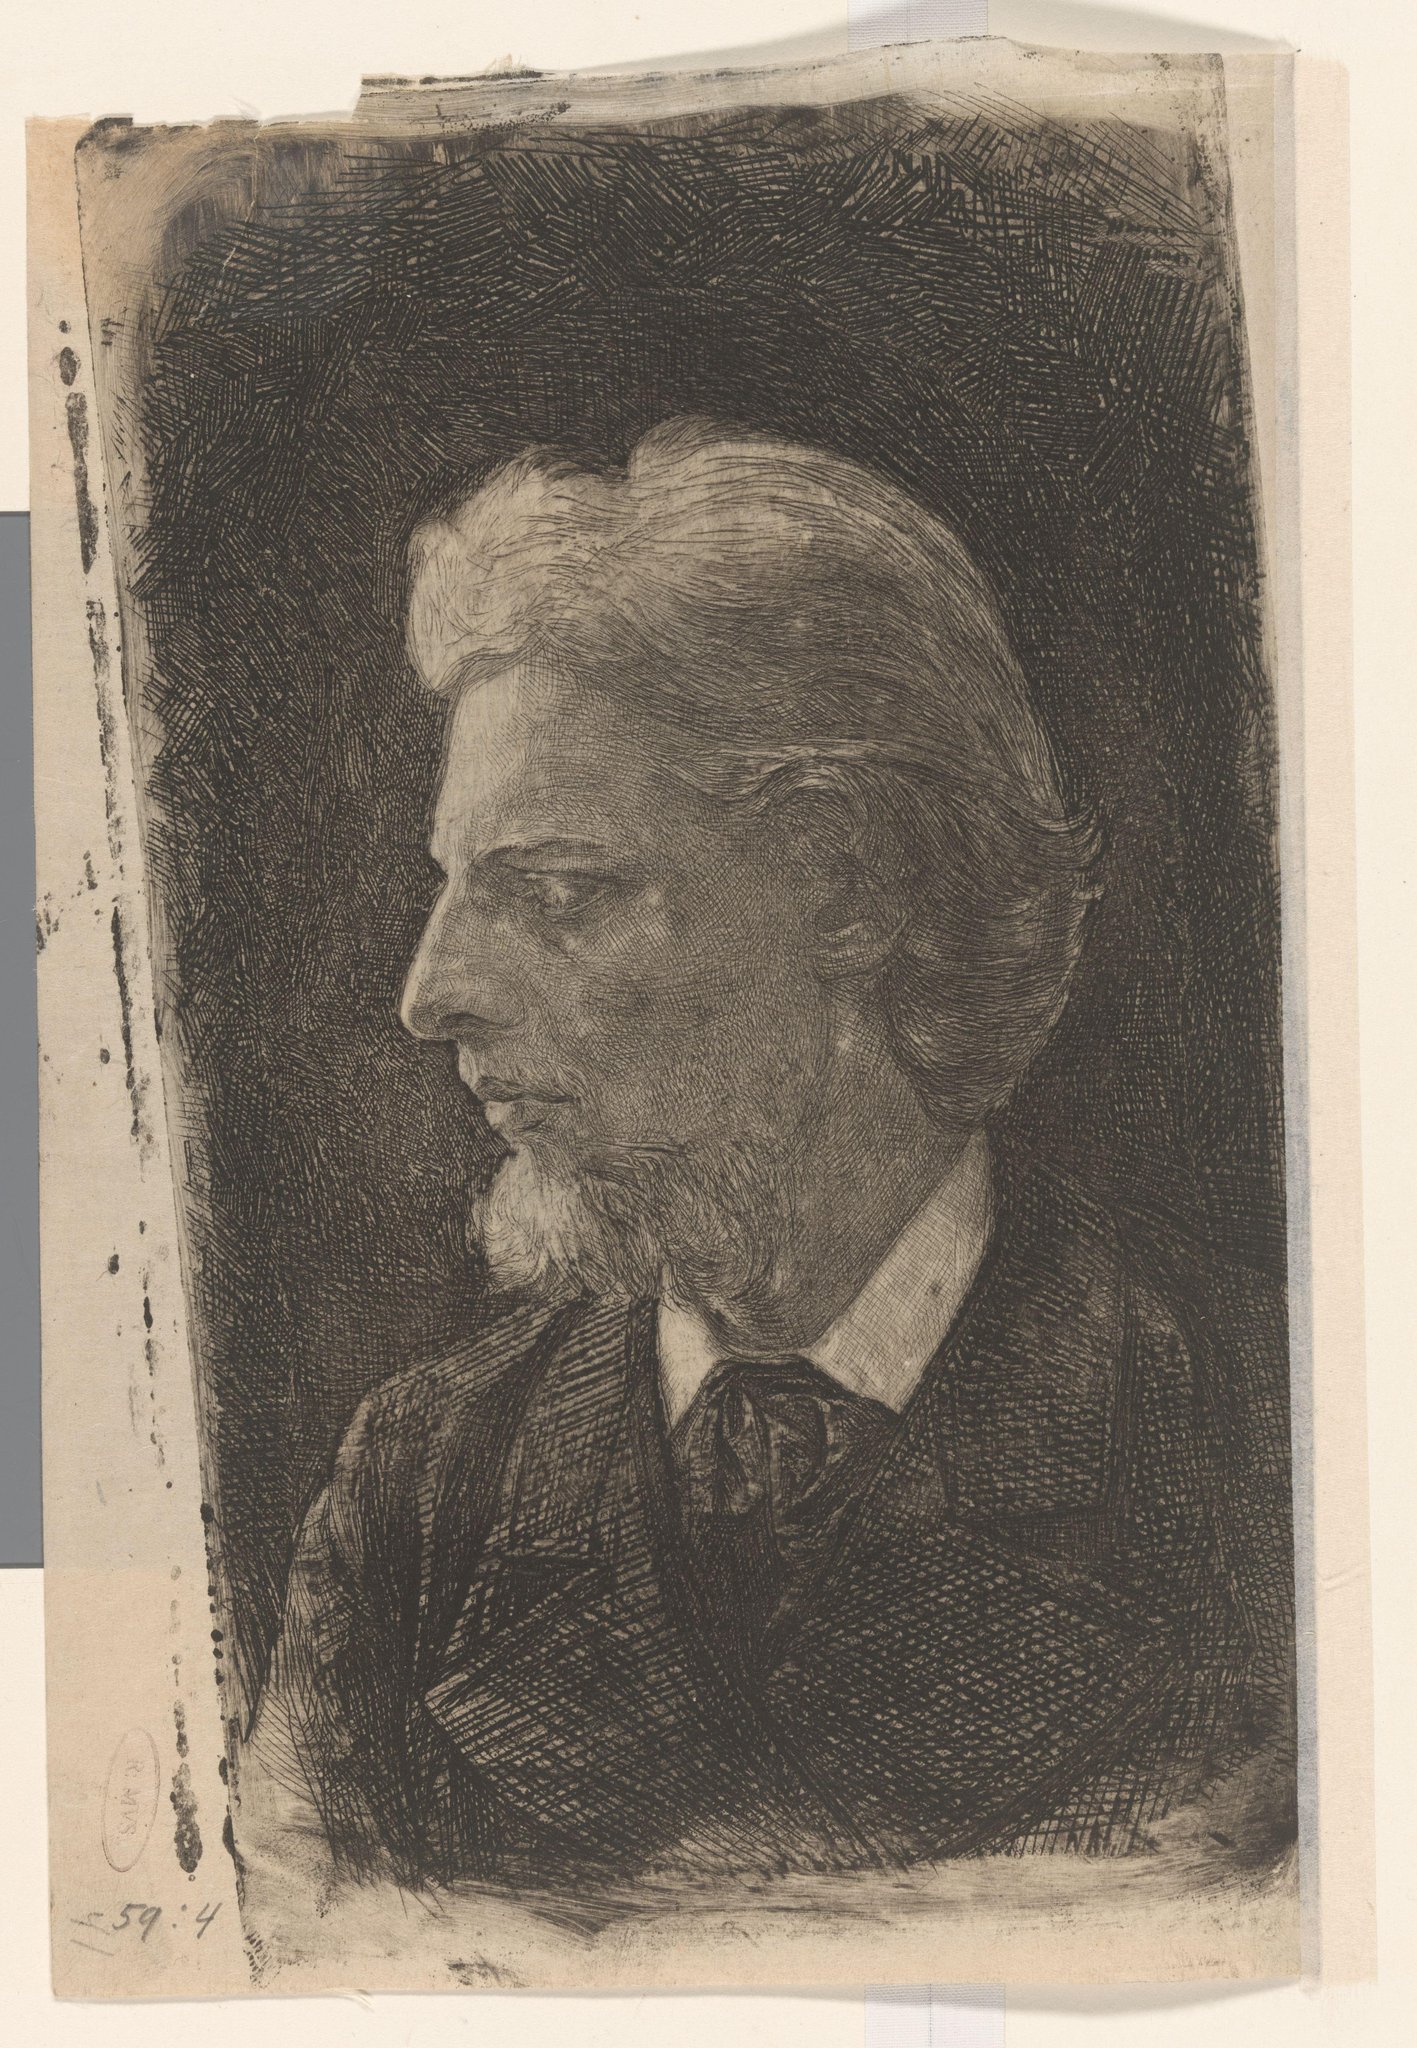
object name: print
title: Portret van Jacques Perk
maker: jan veth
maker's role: designer, draughtsman, painter, print maker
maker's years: 1864-1925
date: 1887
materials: paper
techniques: etching, intaglio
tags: jacques perk, historical persons, writer, poet, author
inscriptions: collector's mark: Lugt 2228